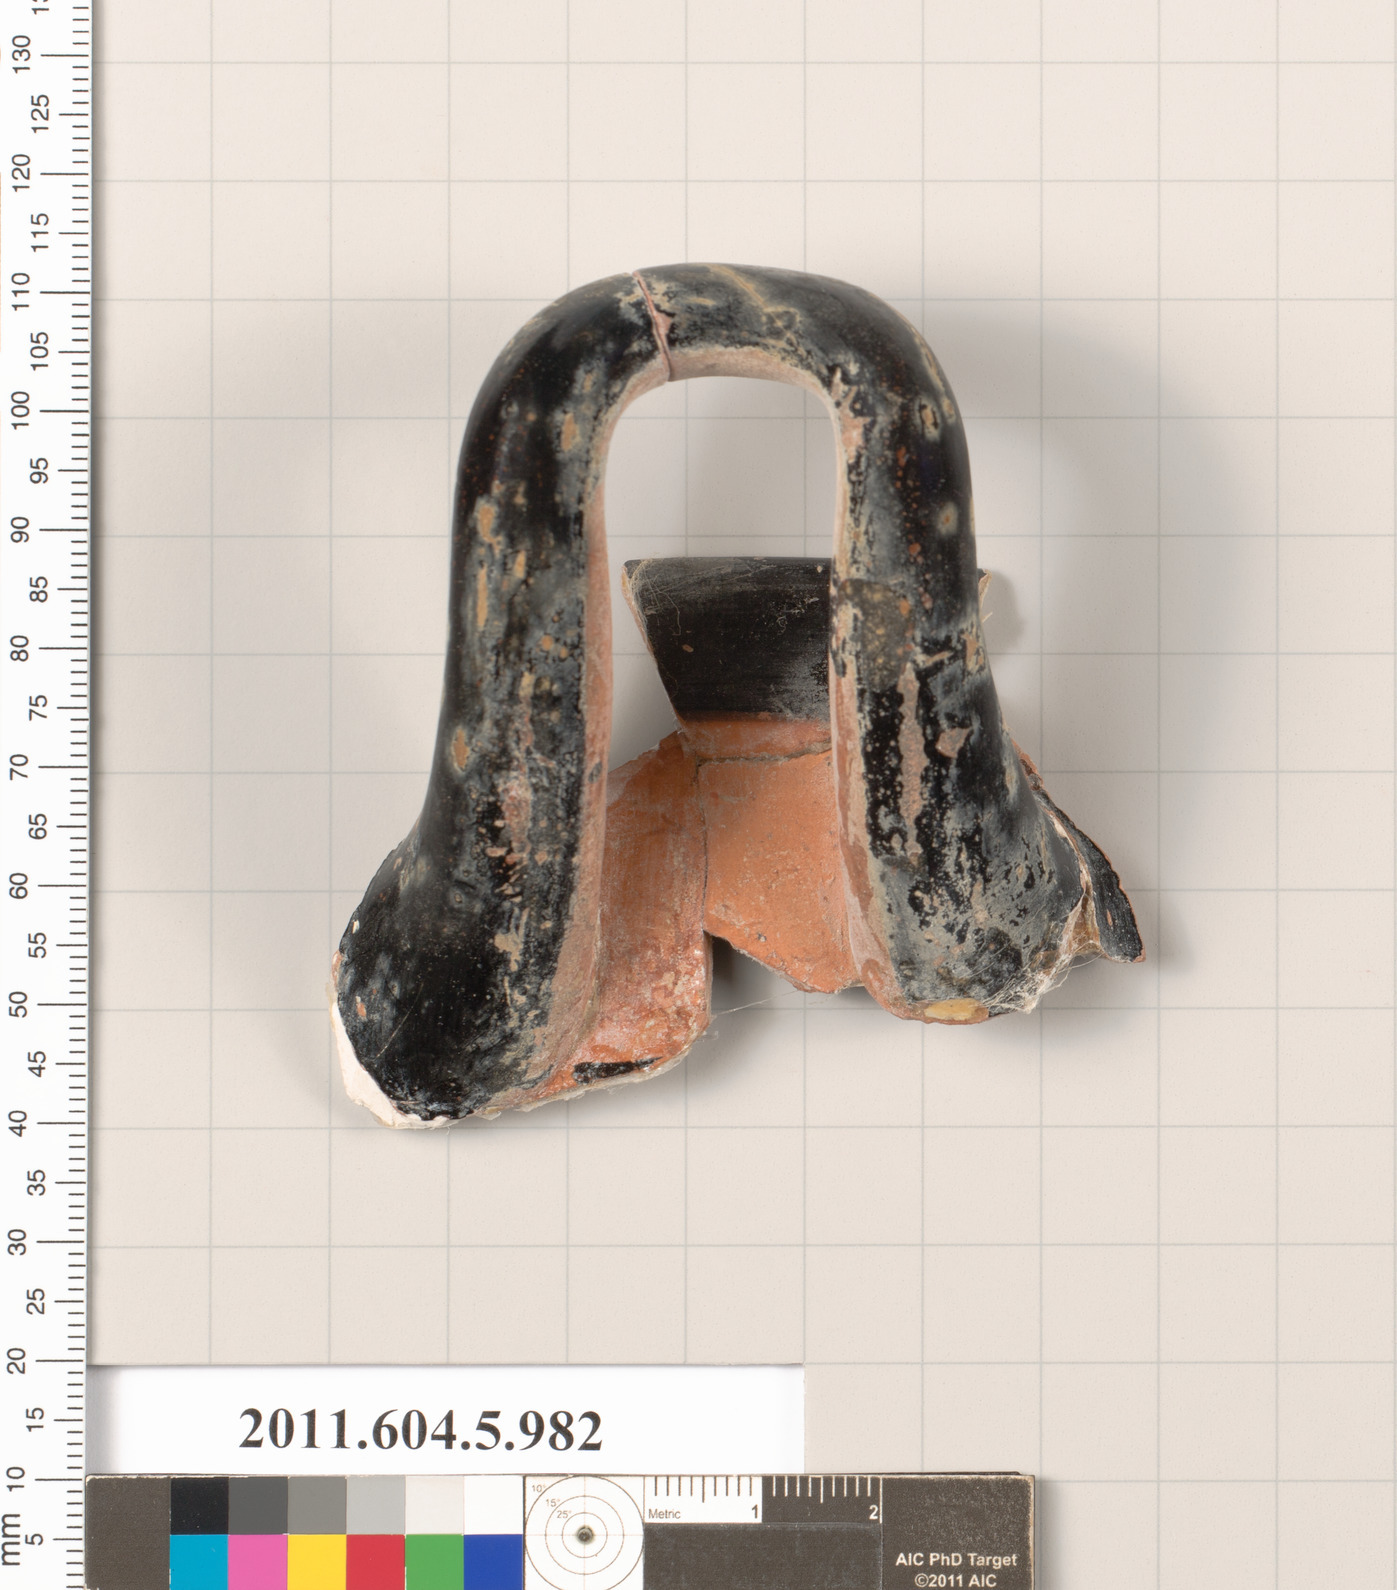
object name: kylix fragment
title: Terracotta rim fragment of a kylix (drinking cup)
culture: greek, attic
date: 600-401 BCE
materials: terracotta